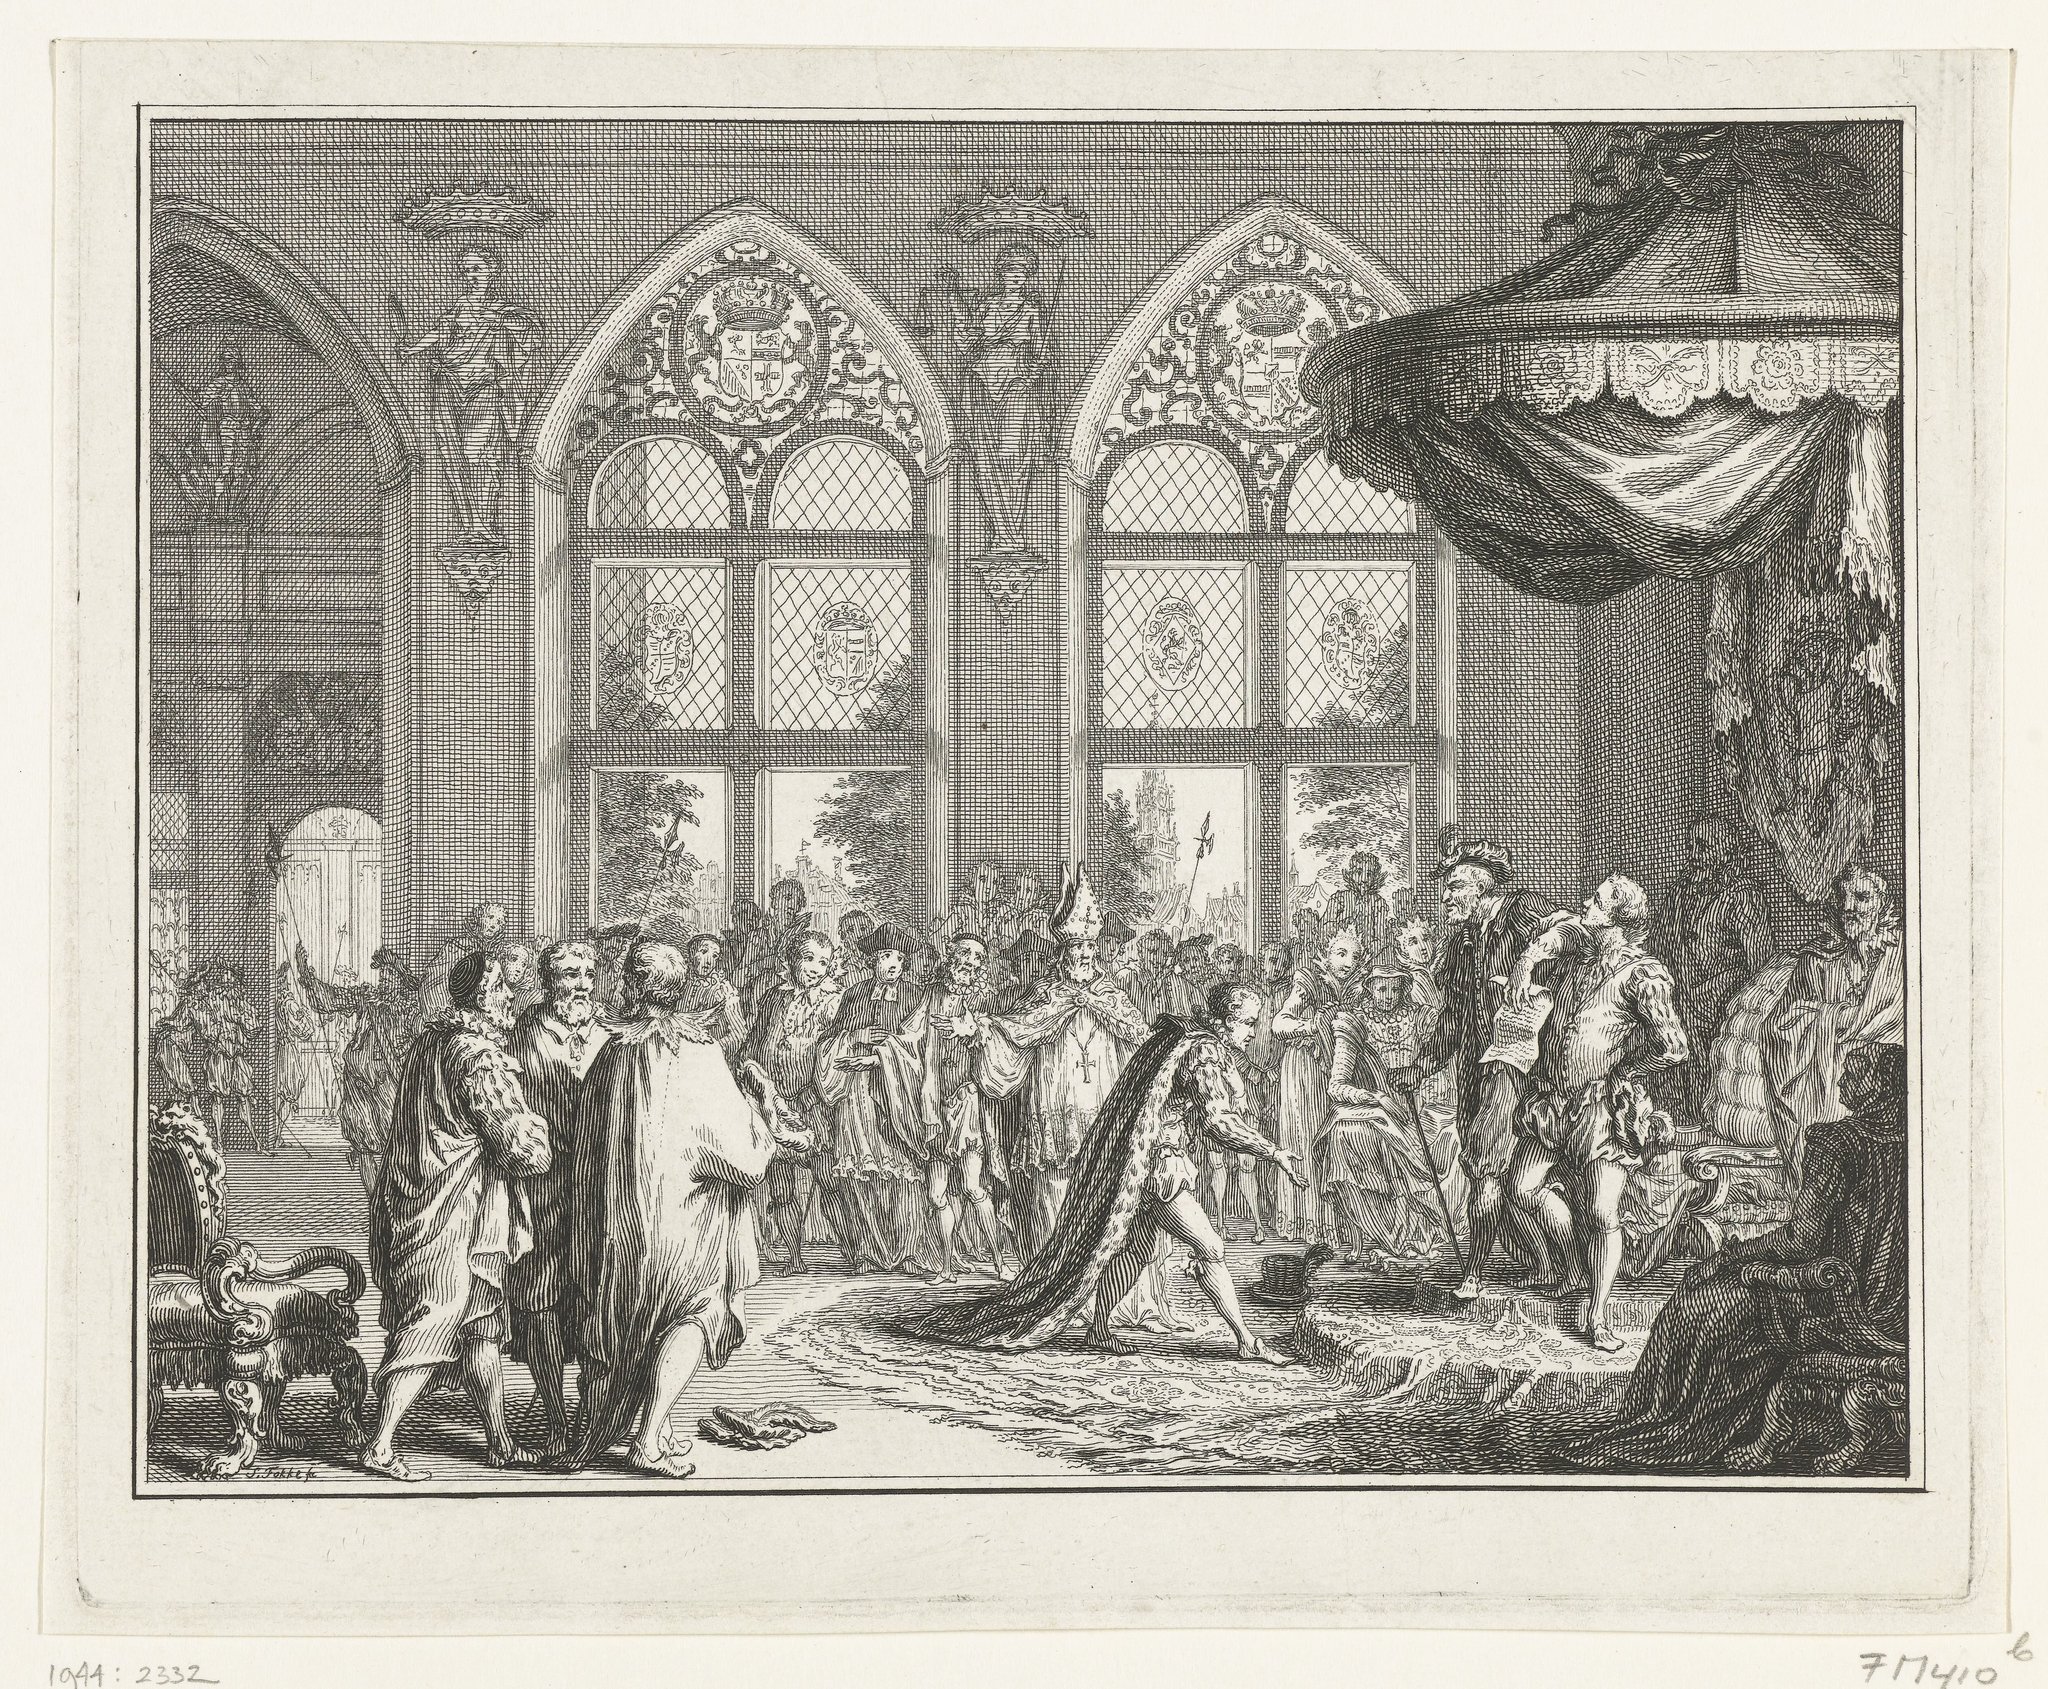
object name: history print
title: Troonsafstand van keizer Karel V, 1555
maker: simon fokke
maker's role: draughtsman, print maker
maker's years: 1712-1784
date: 1747-1759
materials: paper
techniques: etching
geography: northern netherlands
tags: philip ii of spain, william i (prince of orange), ghent, charles v (holy roman emperor and king of spain), voluntary abdication (of a ruler)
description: Troonsafstand van Karel V op 25 oktober 1555 waarin hij de regering van de Nederlanden overdraagt aan zijn zoon Filips. Troonzaal met de keizer staande voor de troon, met een arm steunend op de schouder van jonge Willem van Oranje, voor hen staat Filips.